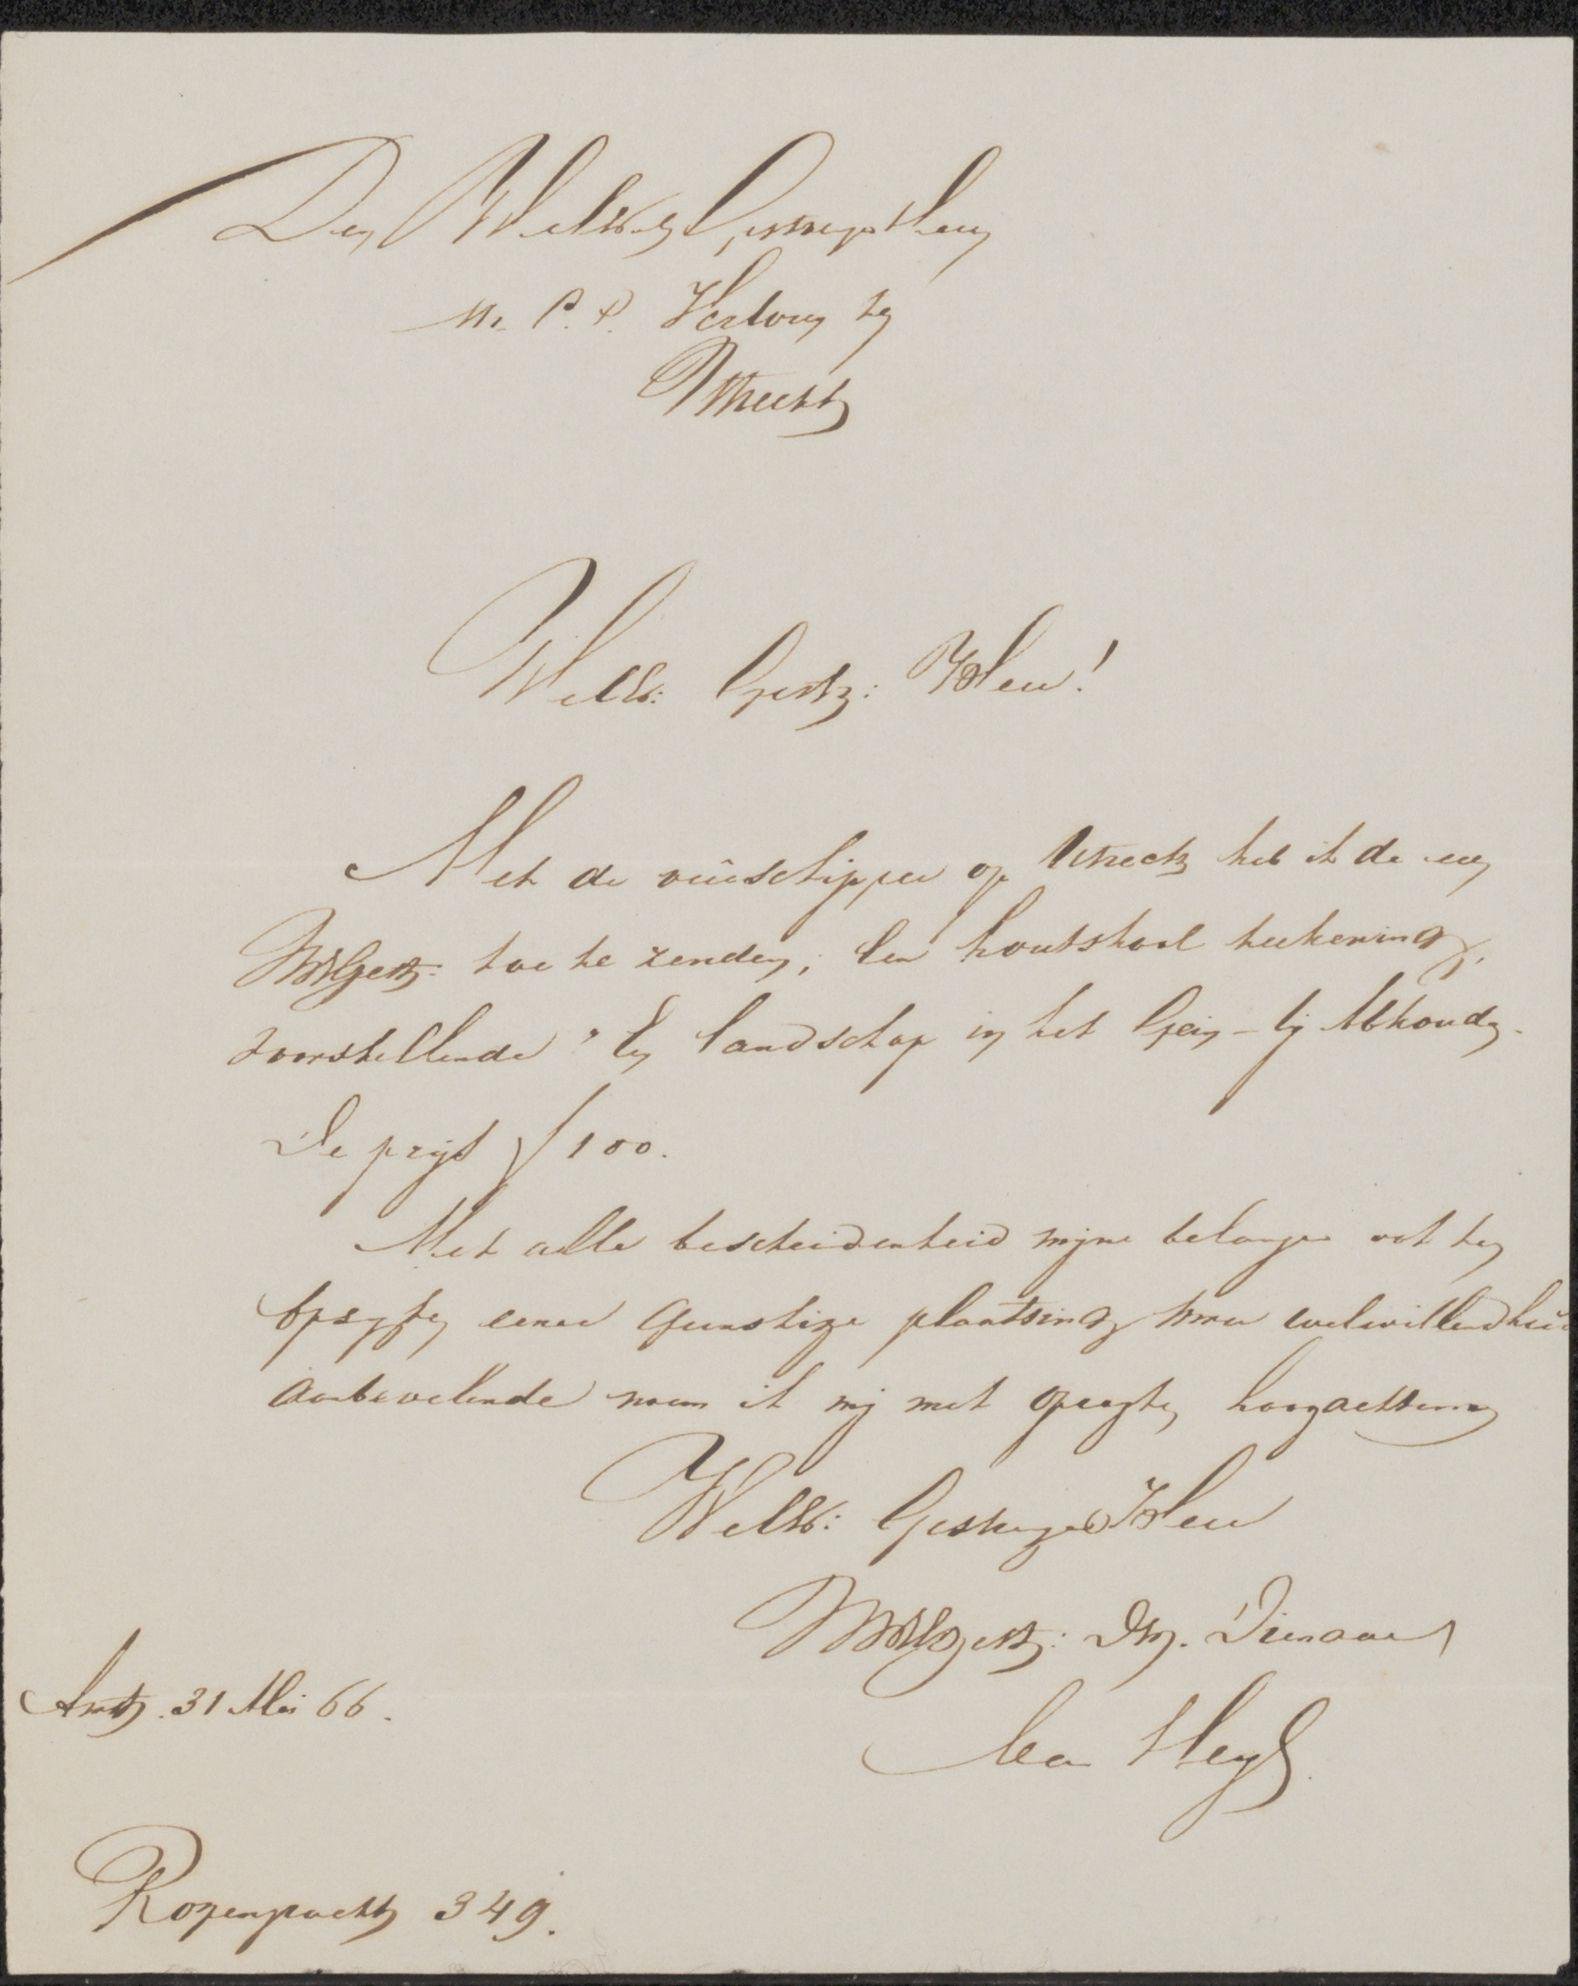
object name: letter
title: Brief aan Pieter Verloren van Themaat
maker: marinus heijl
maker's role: draughtsman, painter, print maker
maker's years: 1836-1931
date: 1866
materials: ink, paper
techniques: pen, writing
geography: amsterdam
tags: pieter verloren van themaat, drawing, exhibition ~ art, money